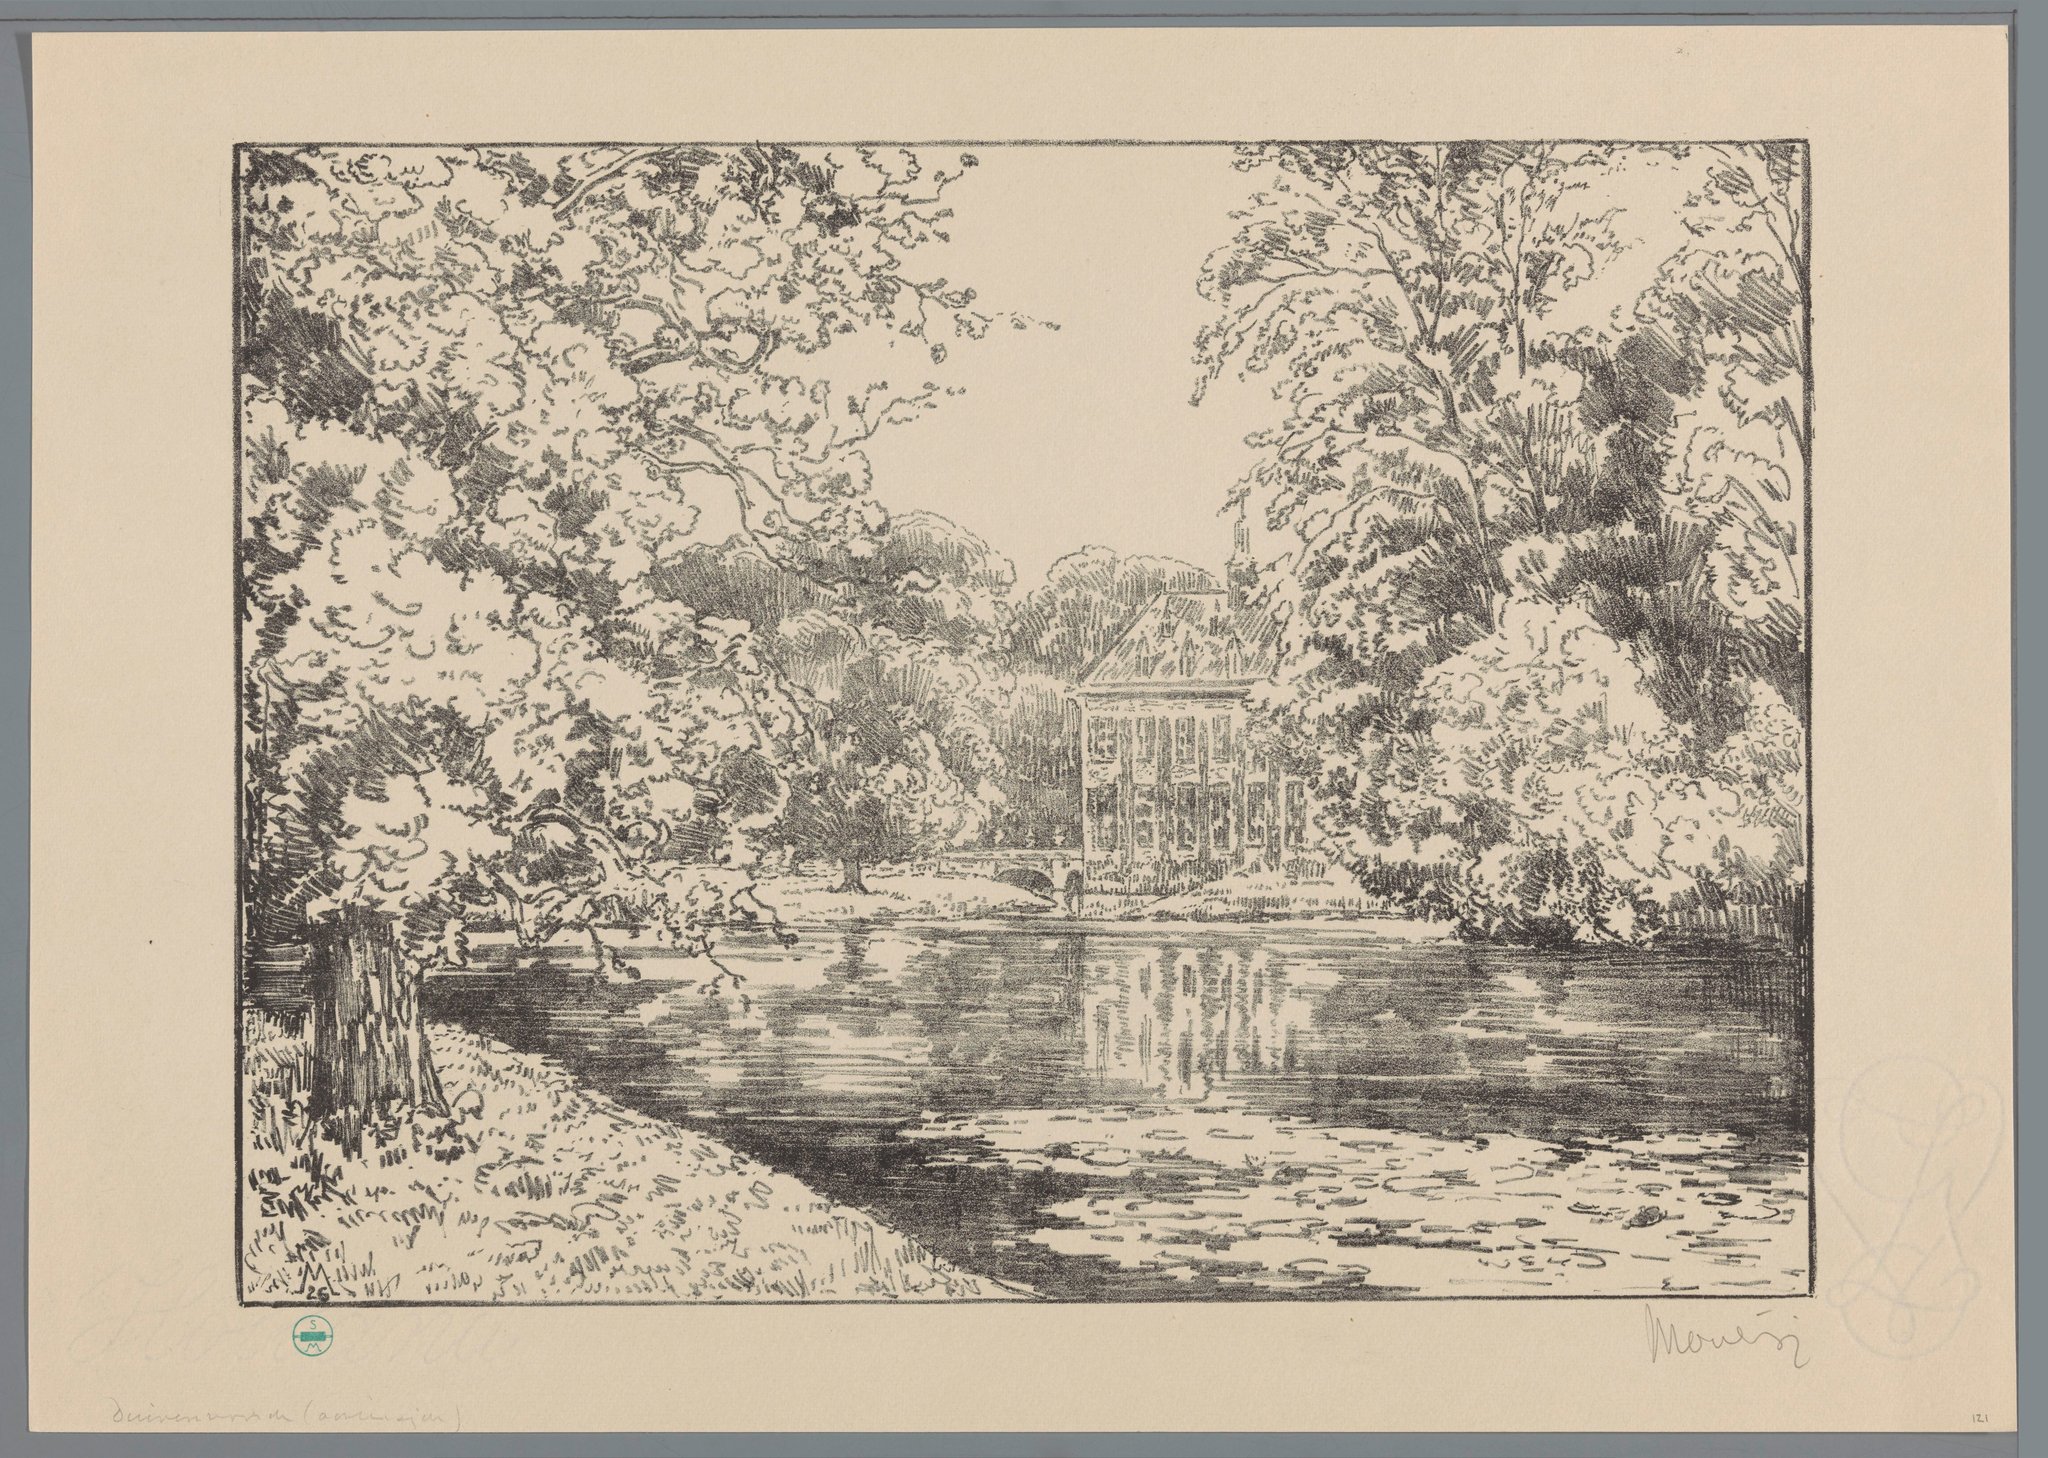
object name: print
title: Oude buitenplaatsen rondom 's-Gravenhage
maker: simon moulijn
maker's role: draughtsman, print maker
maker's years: 1866-1948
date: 1926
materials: paper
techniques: lithograph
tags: landscape with tower or castle, garden pond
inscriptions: stamp: Lugt 2362b, collector's mark: Lugt 2228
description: Prent gebruikt voor: Moulijn, Simon en Gelder, Hendrik Enno van. Oude buitenplaatsen rondom 's-Gravenhage. 's-Gravenhage: Gemeentebestuur, 1929.